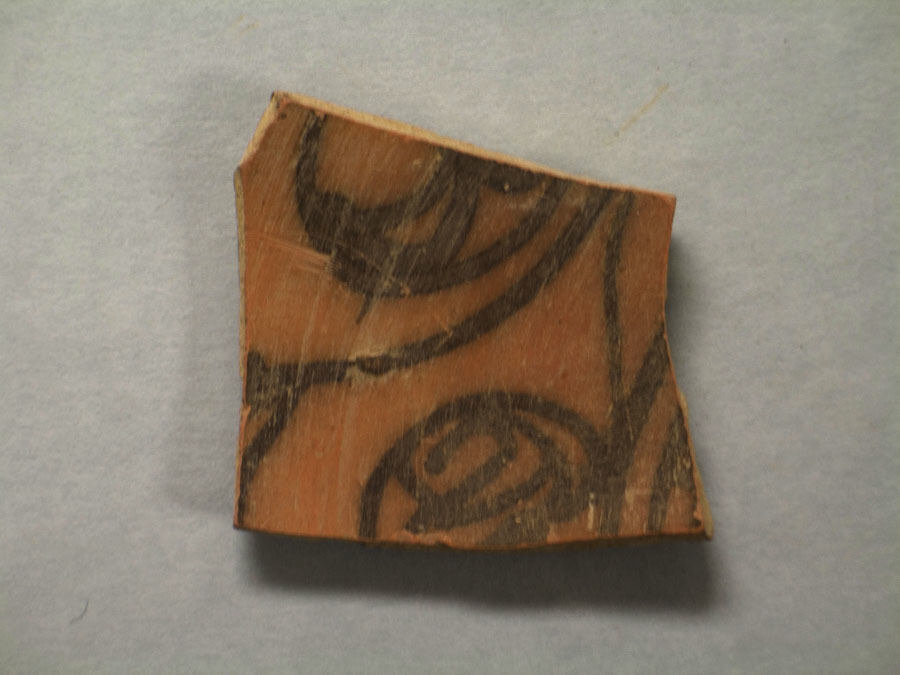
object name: shard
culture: pakistani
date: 301-500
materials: terracotta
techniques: painting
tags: gandhara